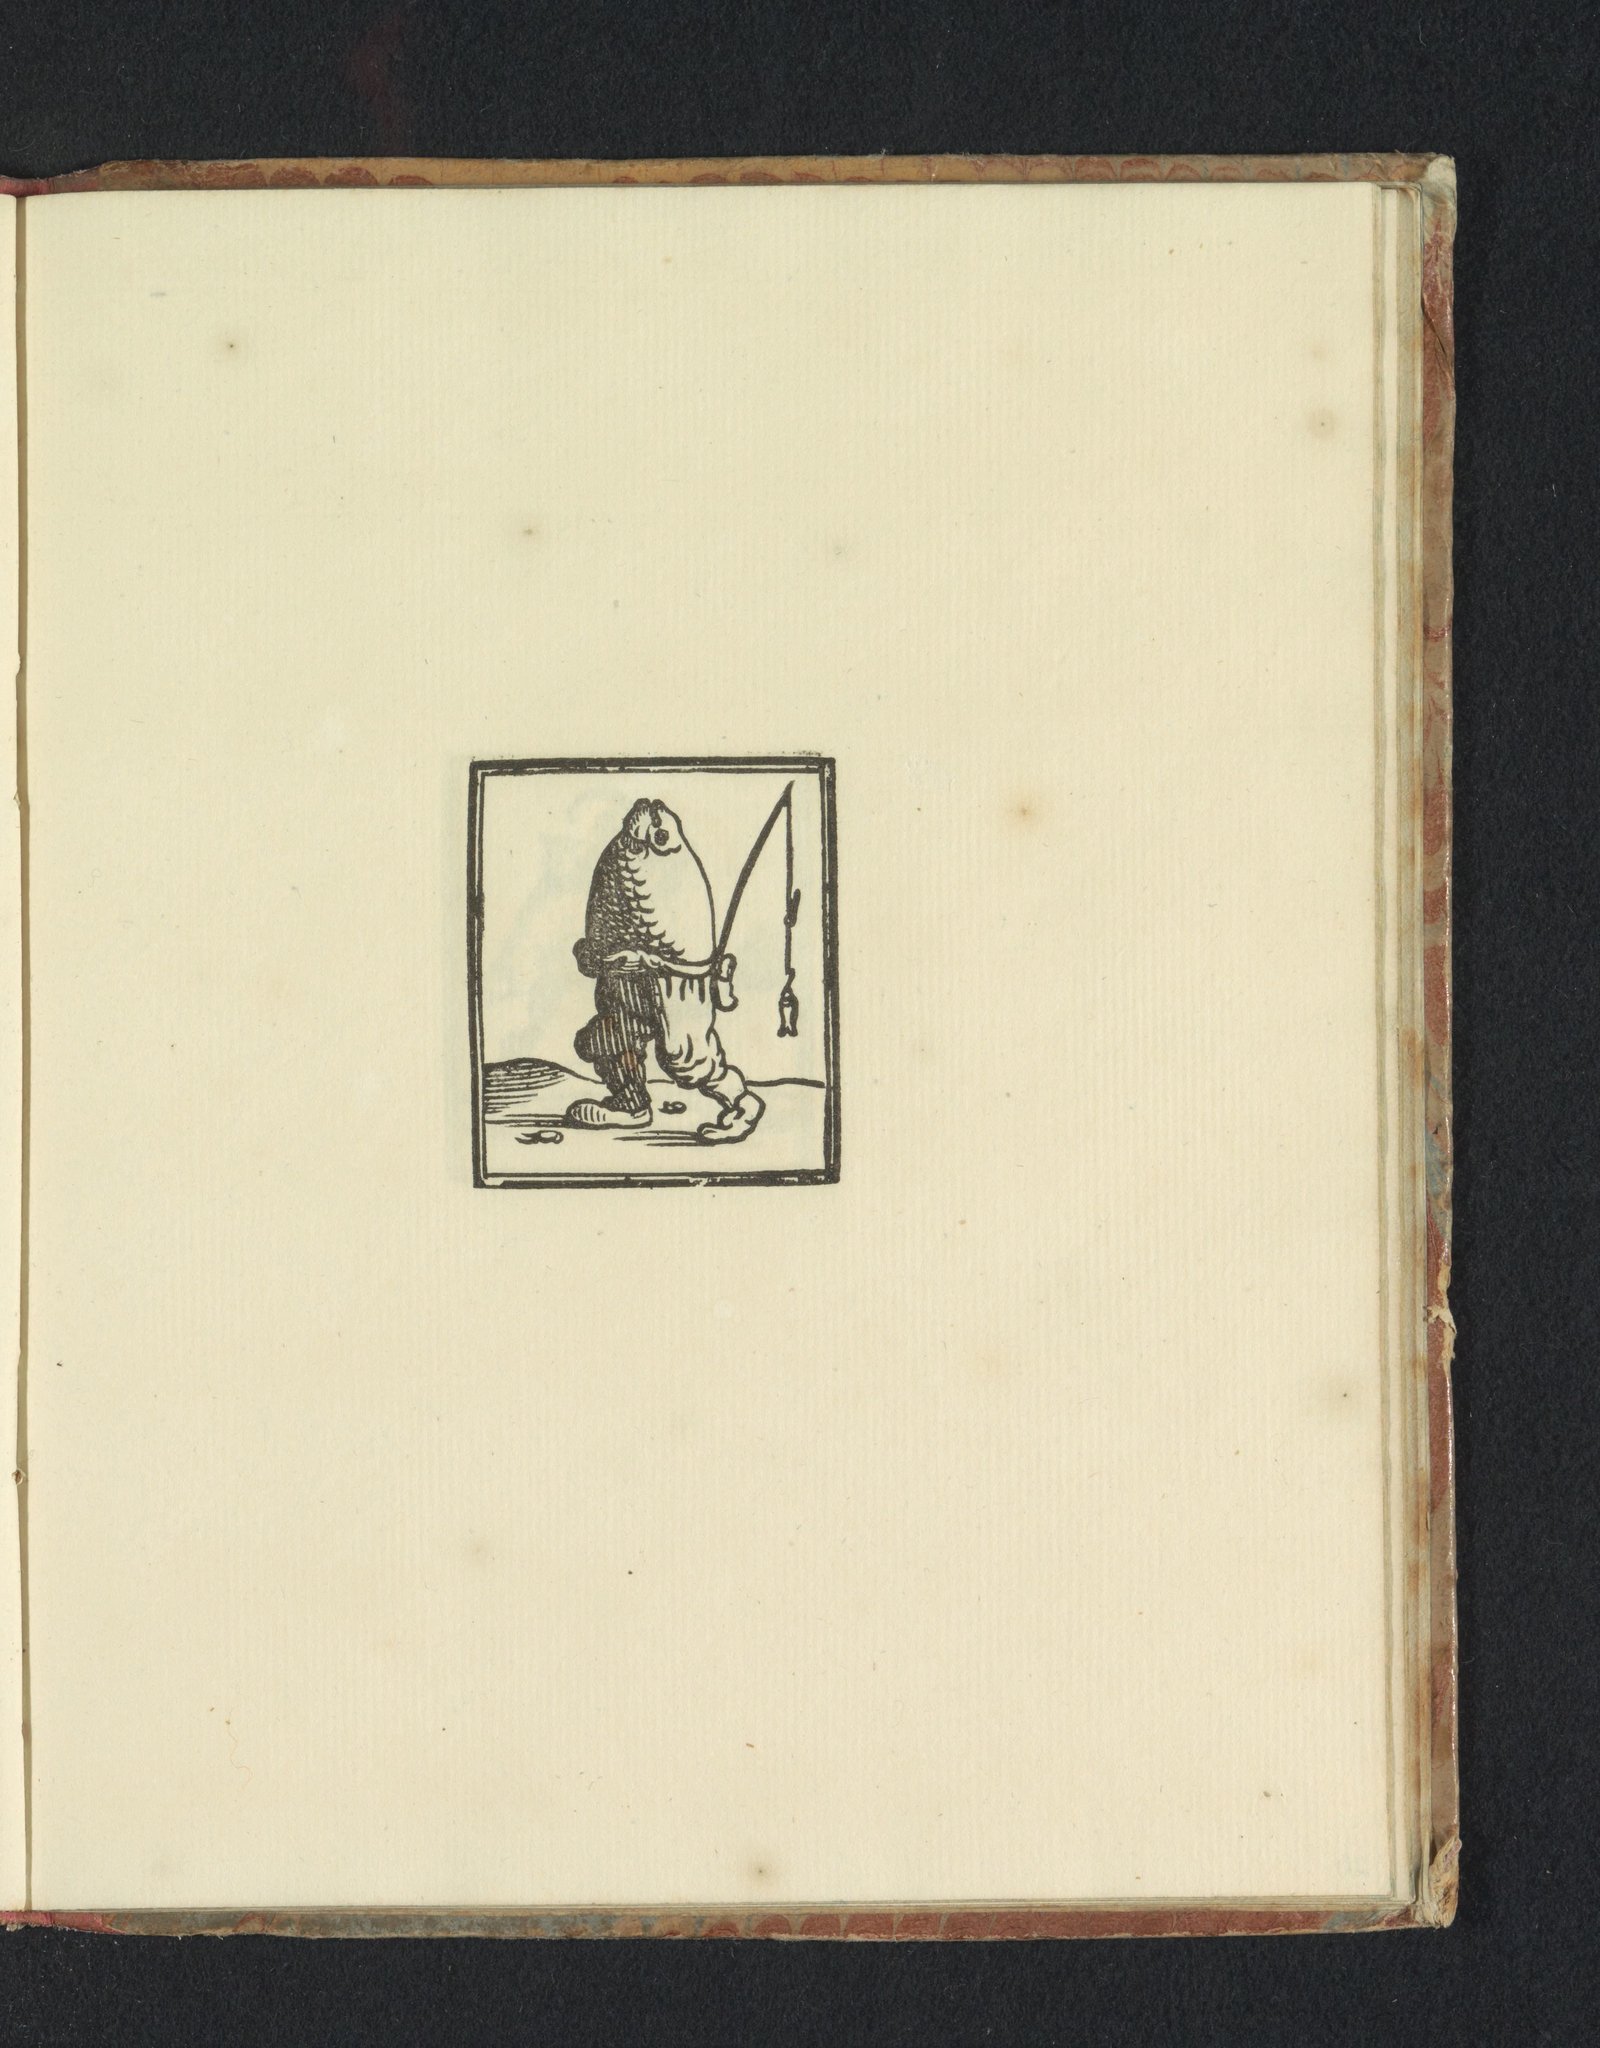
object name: popular print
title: Halfwasse Braassem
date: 1731-1732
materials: paper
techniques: woodcut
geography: haarlem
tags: caricatures (human types)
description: Koddige figuur, in het onderschrift in de overzichtsprent draagt deze figuur de naam: Halfwasse Braassem. Onderdeel van het boekje: XXXVI. aartige figuuren, geinventeert door Izaak van Ostade tot Haarlem [1731-1732].